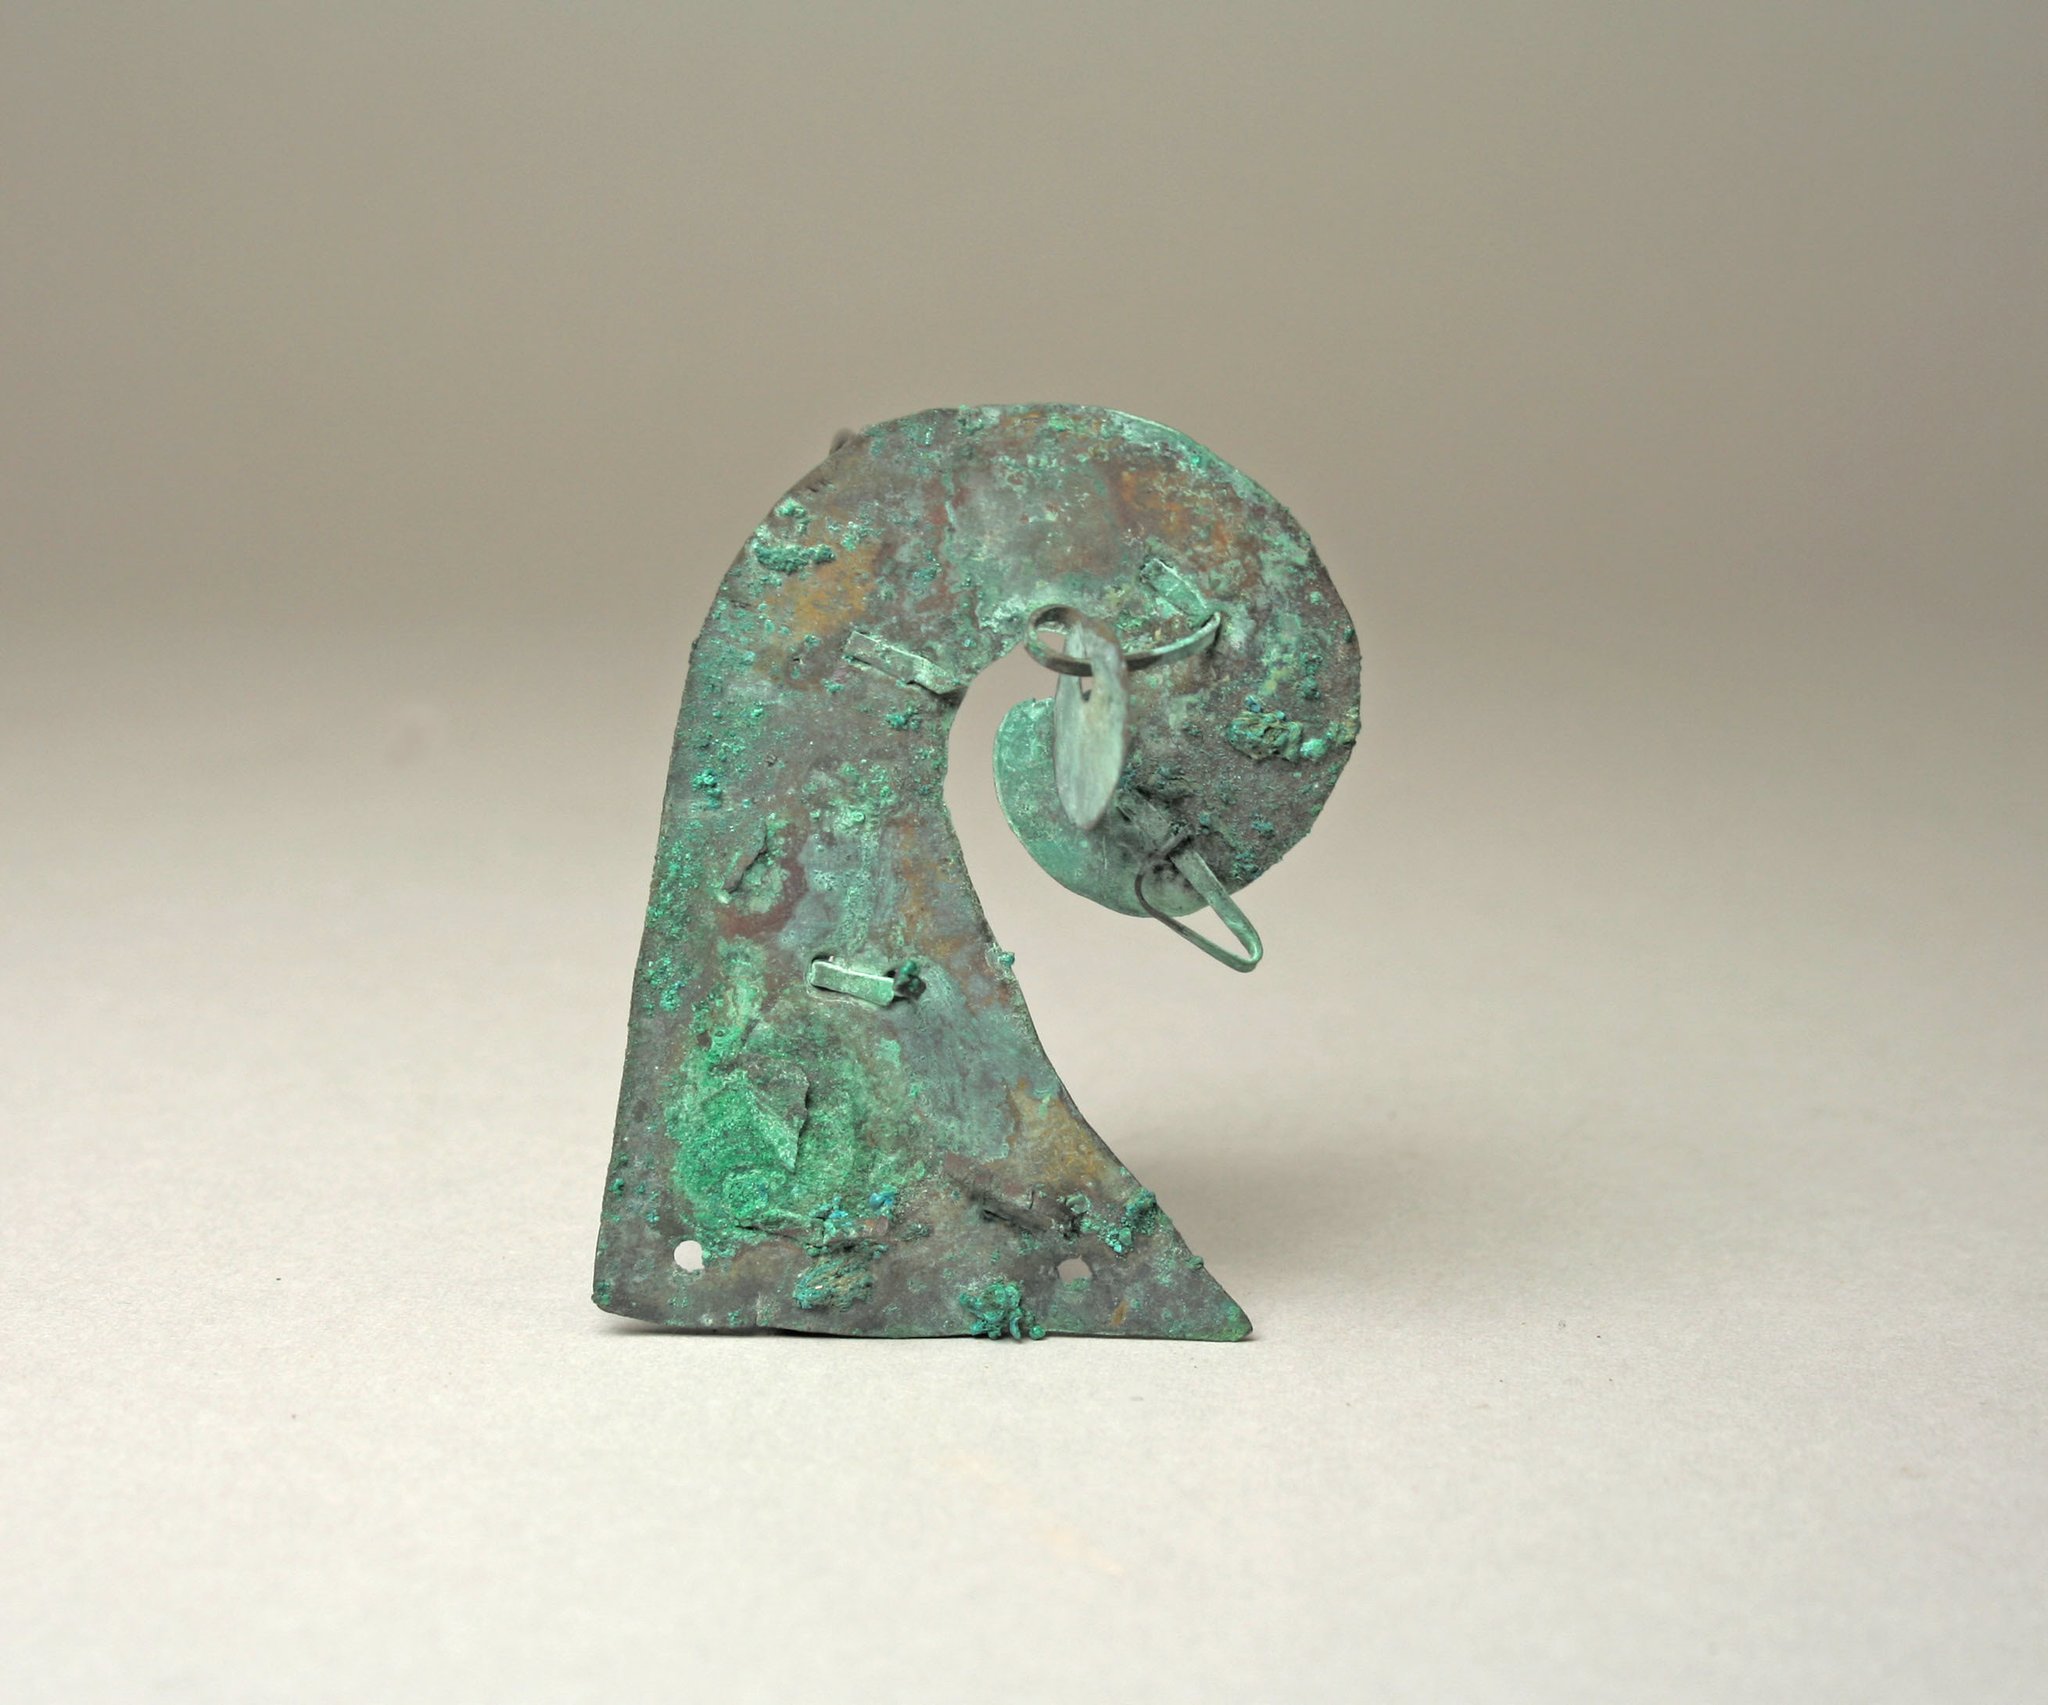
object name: ornament fragment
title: Ornament Fragment (?)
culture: moche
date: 501-700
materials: metal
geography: peru